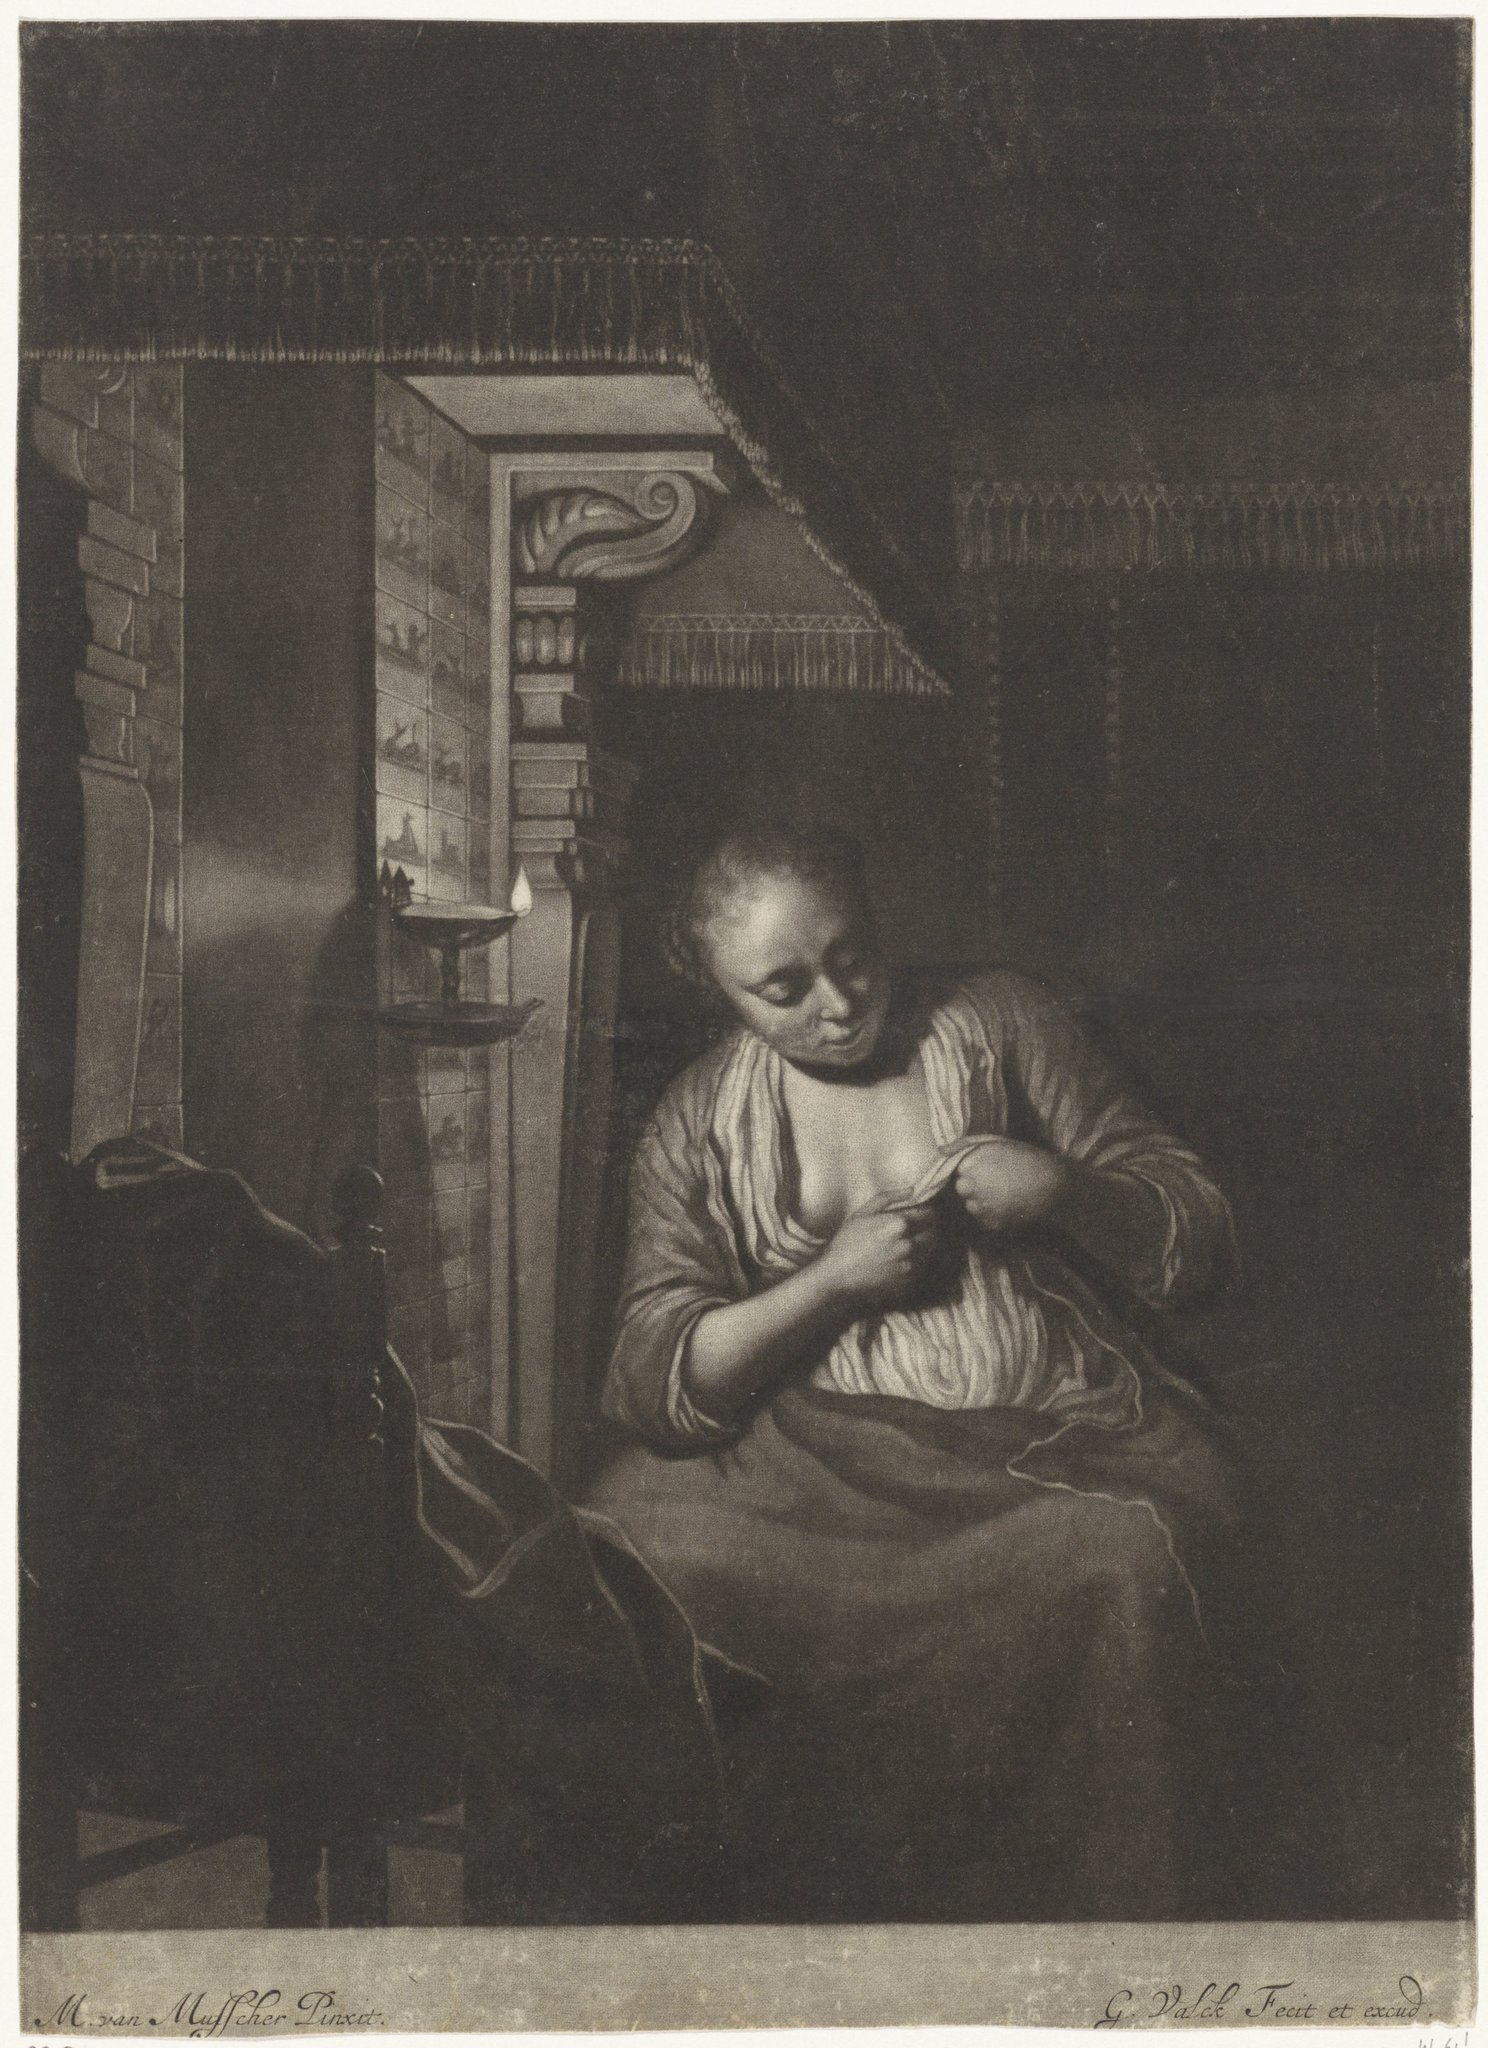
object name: print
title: Zich vlooiende vrouw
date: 1662-1726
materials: paper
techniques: mezzotint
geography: london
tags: chimney, oil-lamp, tiles, bricks ~ building material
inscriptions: collector's mark: Lugt 2228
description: Bij het licht van een olielamp zoekt een jonge vrouw in haar kleding naar vlooien. Ze zit bij een schouw die gedecoreerd is met tegeltjes.